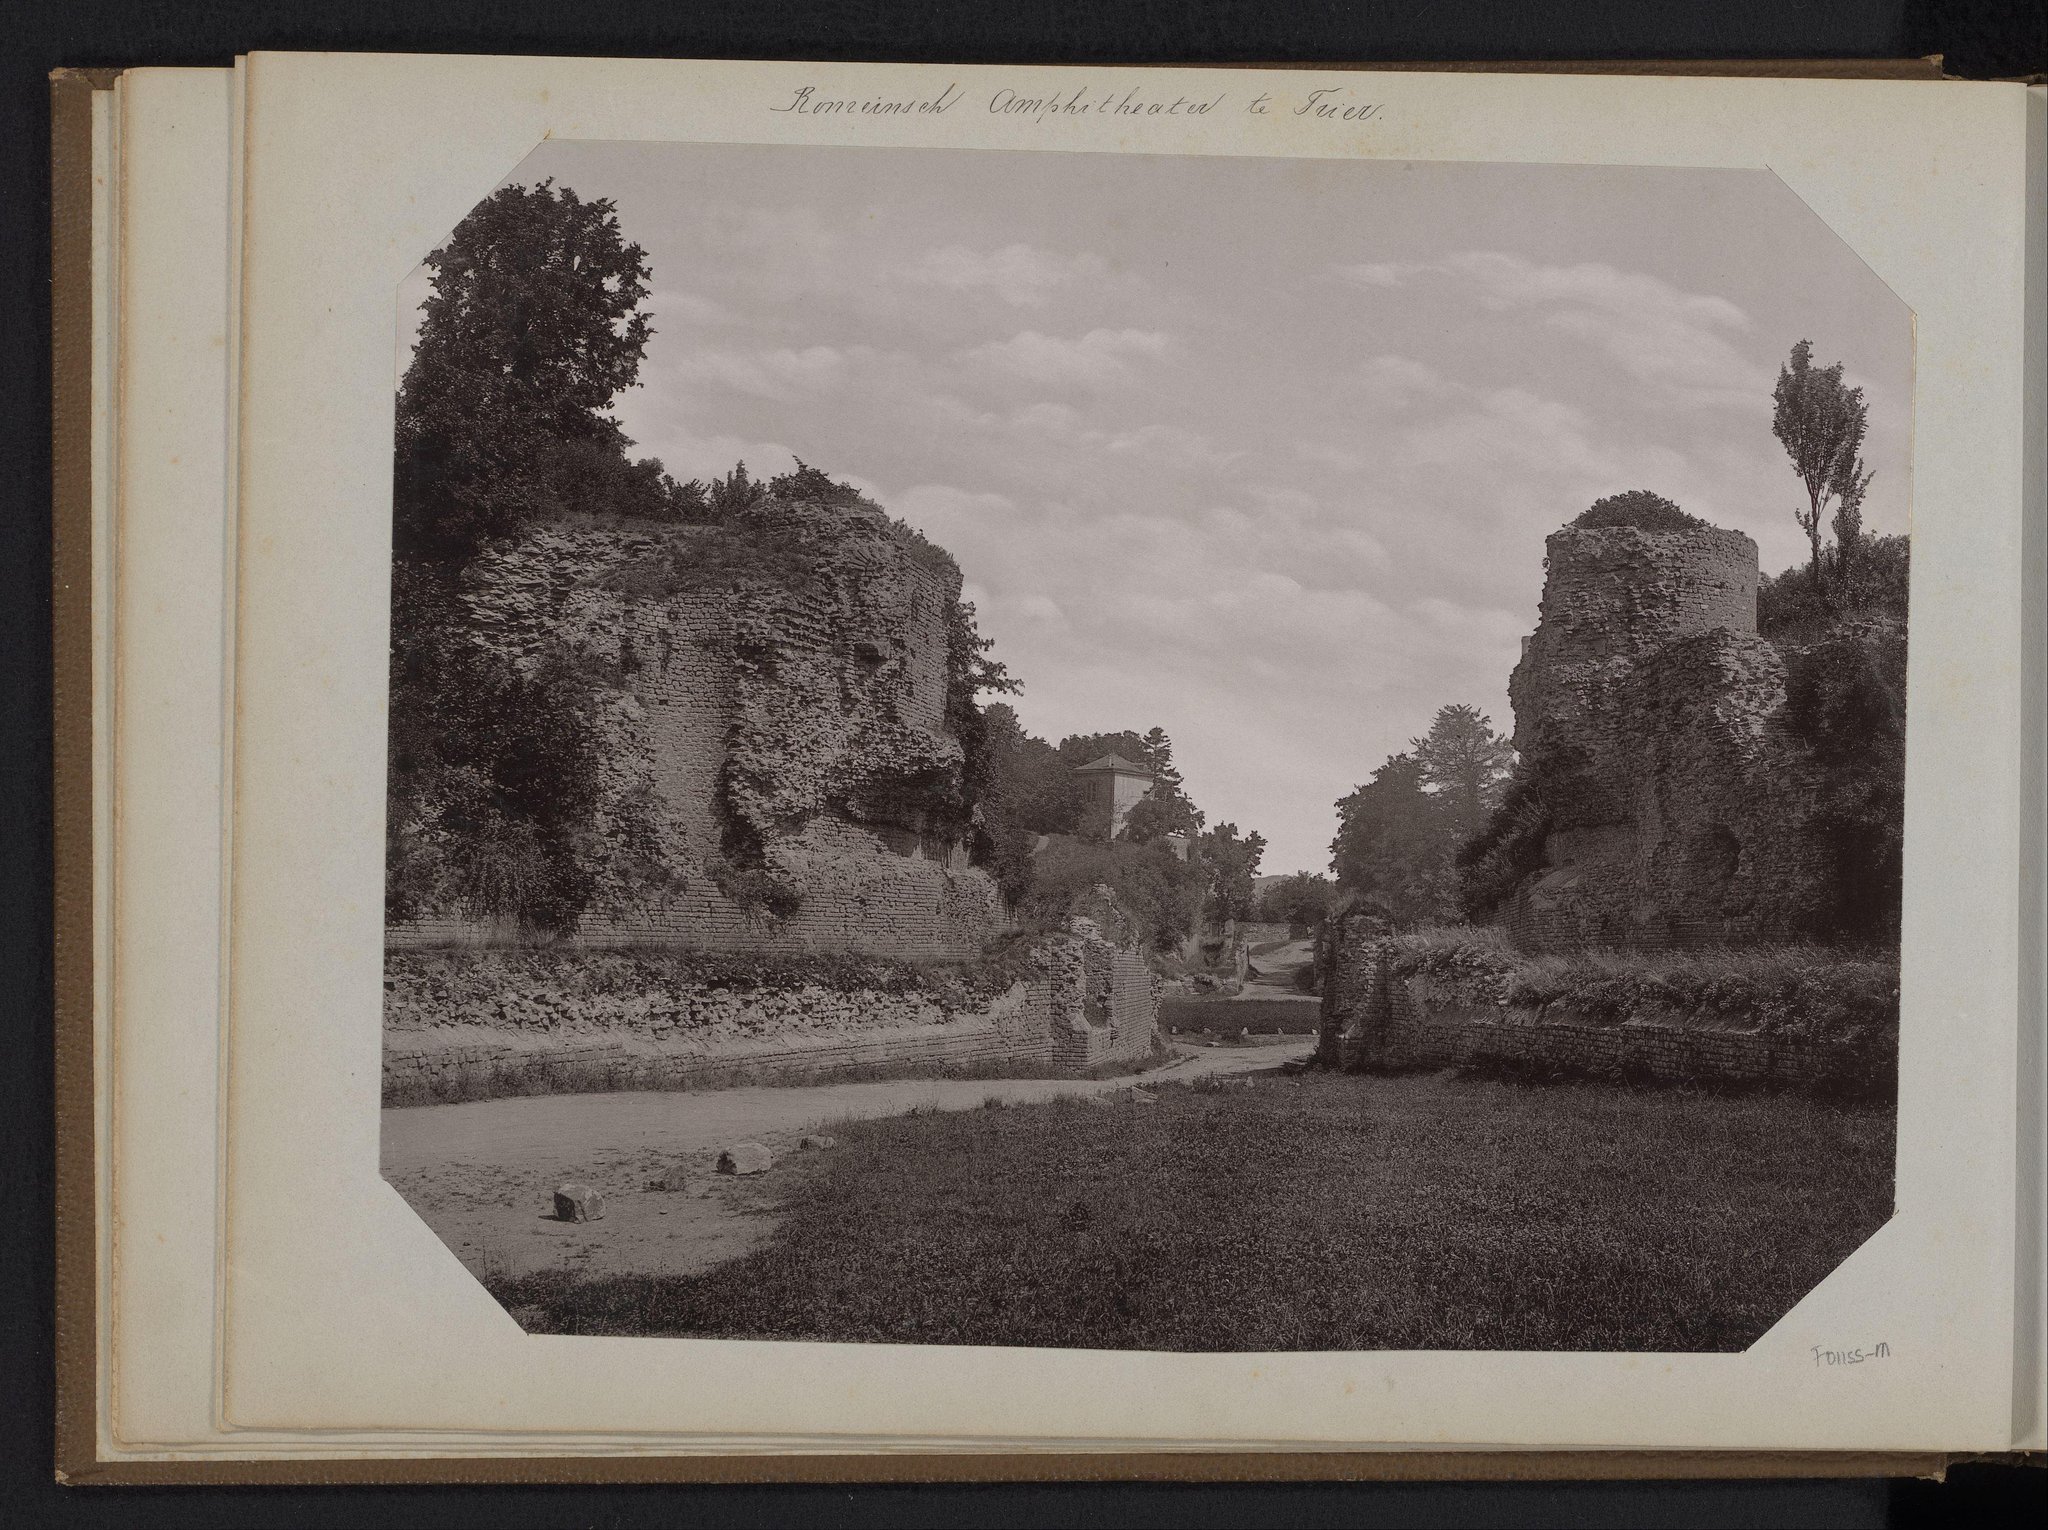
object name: photomechanical print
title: Gezicht op de ruïnes van het Amfitheater van Trier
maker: Anonymous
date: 1890-1896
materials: paper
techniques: photograph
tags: landscape with ruins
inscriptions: annotation: ‘Romeinsch amphitheater te Trier’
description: Deze prent maakt deel uit van een album.